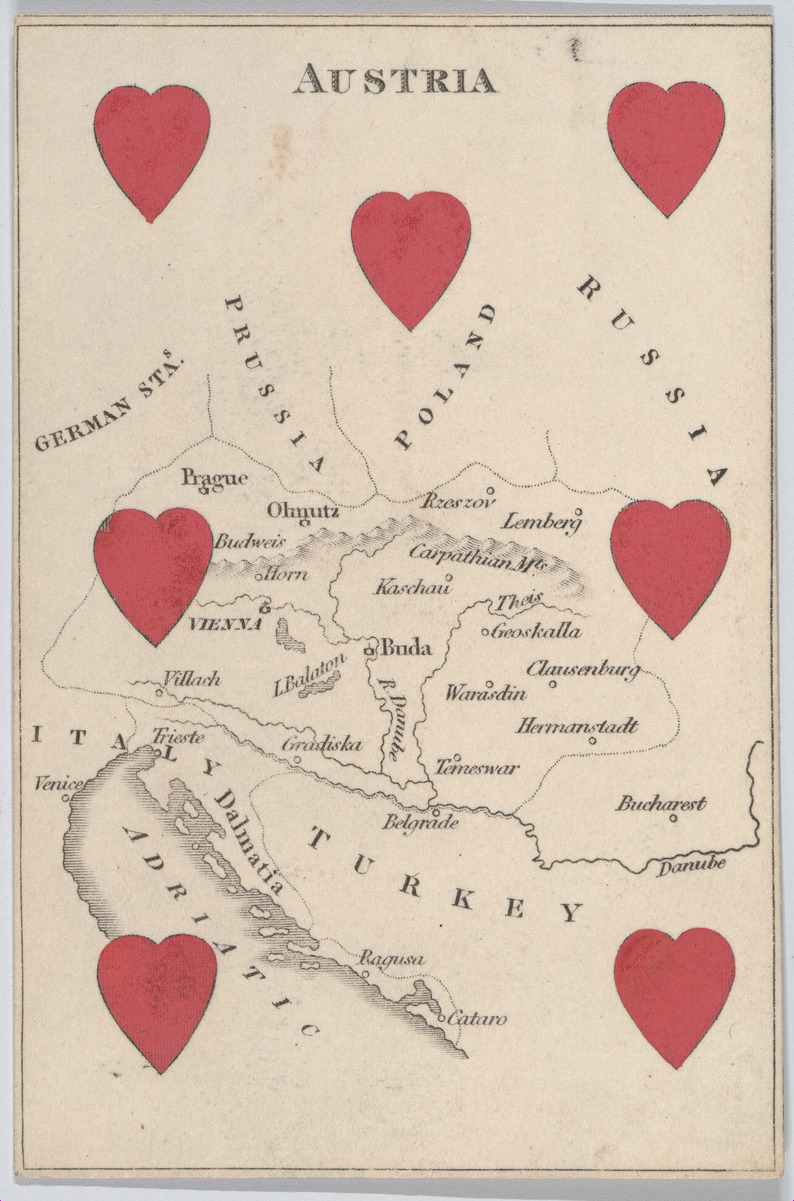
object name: print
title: Austria, from "Court Game of Geography"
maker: william and henry rock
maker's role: publisher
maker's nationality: british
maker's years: 1821-1884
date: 1838-1855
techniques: engraving, hand coloring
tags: playing cards,maps